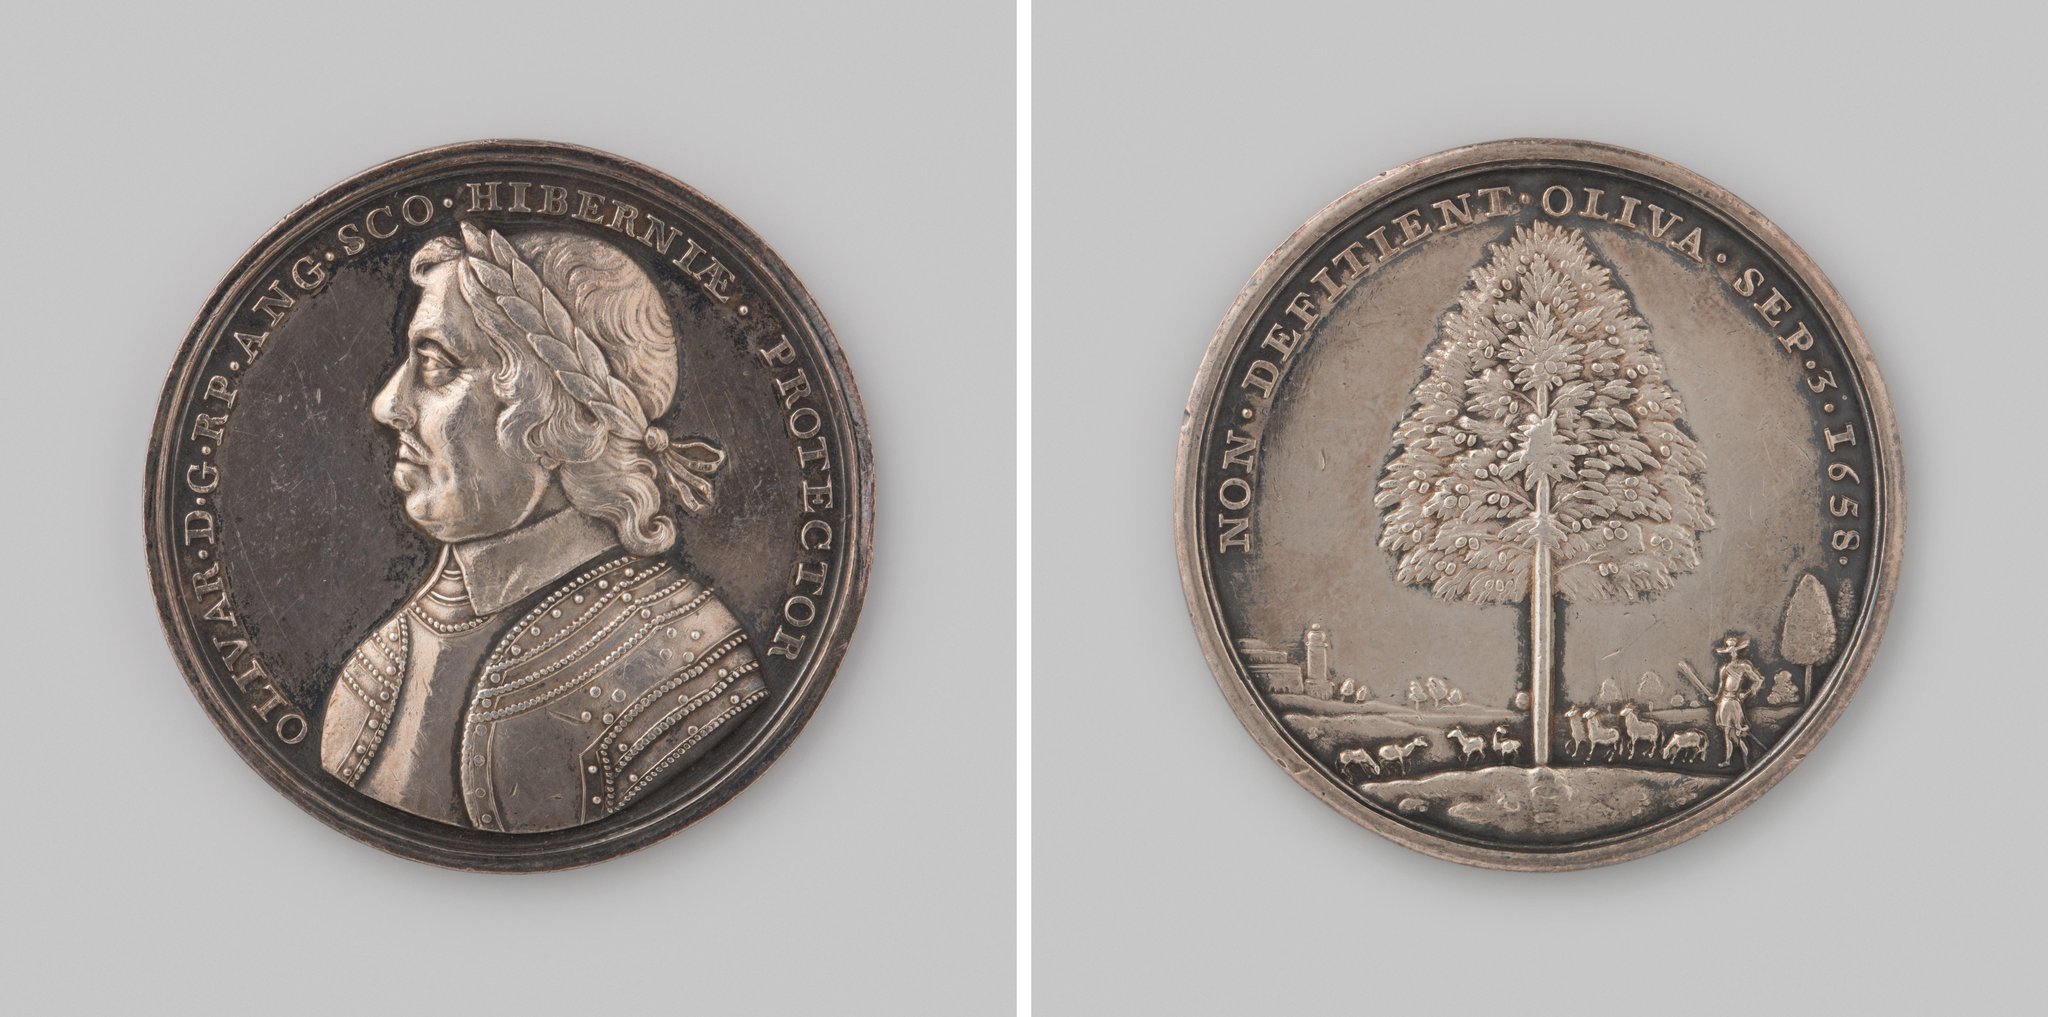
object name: medal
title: Overlijden van Oliver Cromwell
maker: Anonymous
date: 1658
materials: silver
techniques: striking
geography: netherlands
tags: london, oliver cromwell, trees: olive-tree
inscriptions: inscription: ‘NON . DEFITIENT . OLIVA . SEP . 3 . 1658 .’, inscription: ‘OLIVAR . D . G . RP . ANG . SCO . HIBERNIAE . PROTECTOR’